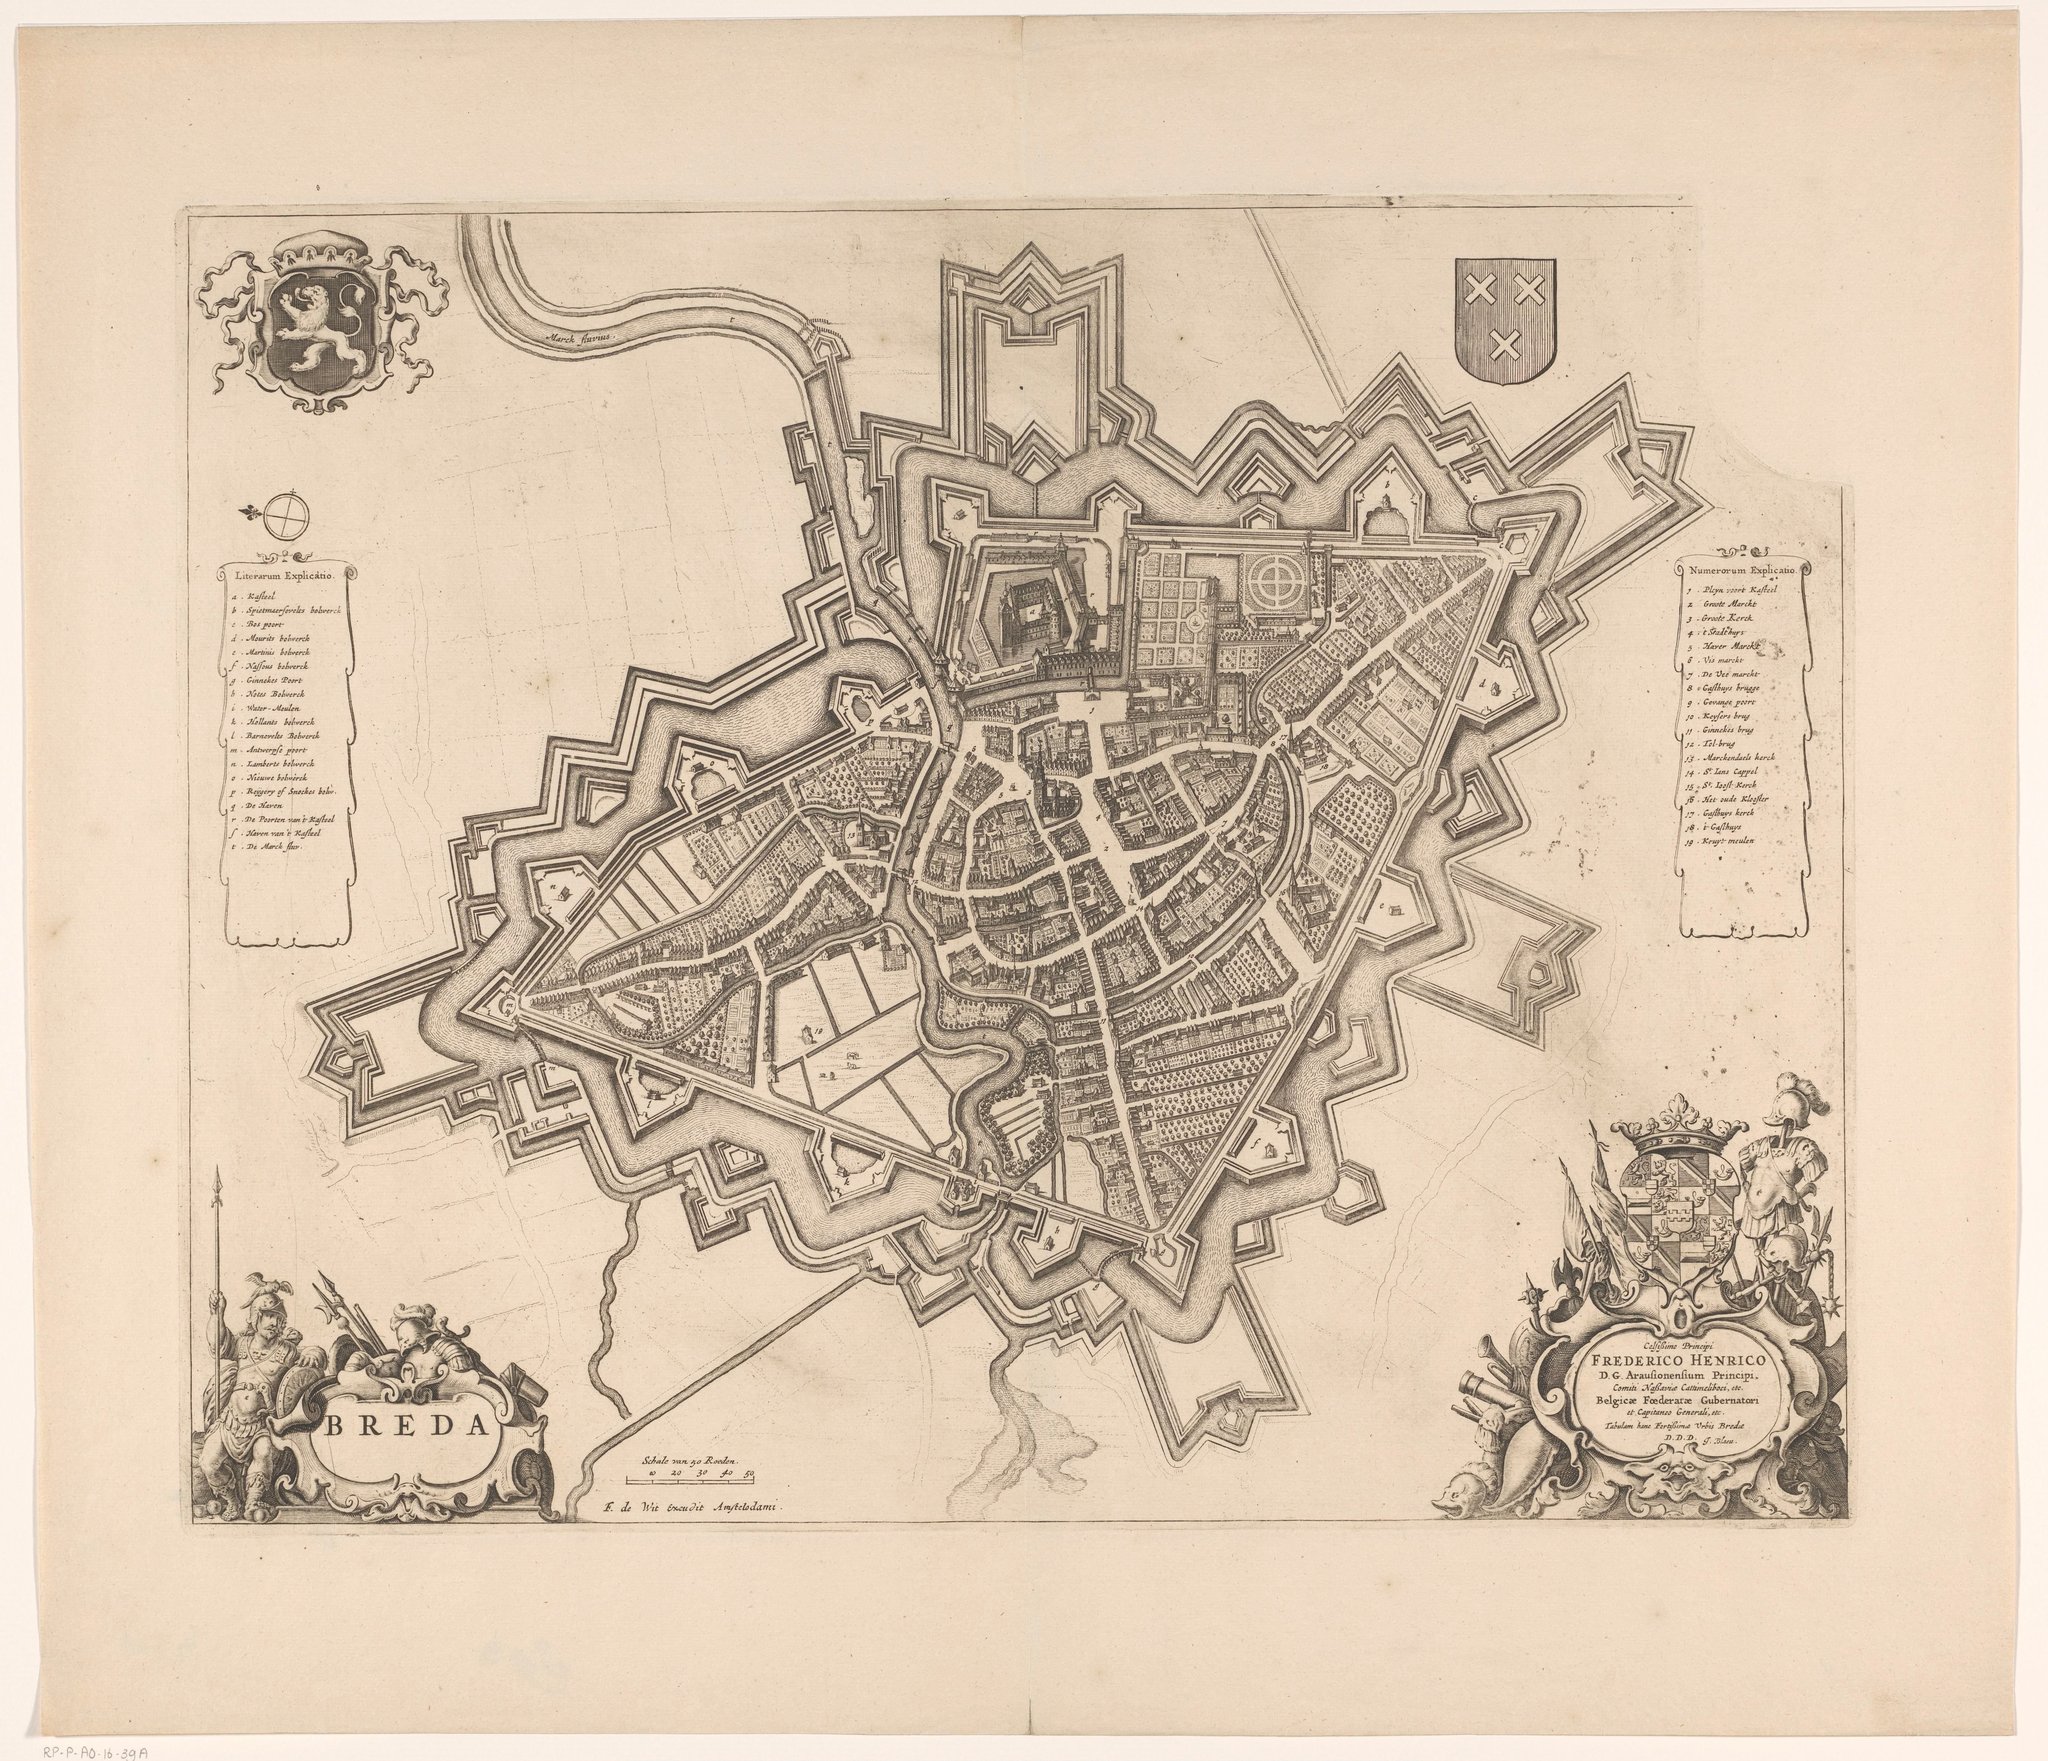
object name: area plan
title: Plattegrond van Breda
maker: Anonymous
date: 1700-1728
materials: paper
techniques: engraving, etching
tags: coat of arms (as symbol of the state, etc.) (+ city; municipal), armour, weapons, fortified city, maps of cities, coat of arms (as symbol of the state, etc.) (+ province; provincial), armorial bearing, heraldry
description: Plattegrond van Breda in vogelvluchtperspectief. Linksonder de titelcartouche met daarnaast een schaalstok: Schale van 50 Roeden. Linksboven het wapen van Brabant. Rechtsboven het wapen van Breda. Links een legenda a-t, rechts een legenda 1-19. Rechtsonder een cartouche met de opdracht aan Frederik Hendrik (prins van Oranje) met zijn wapen.